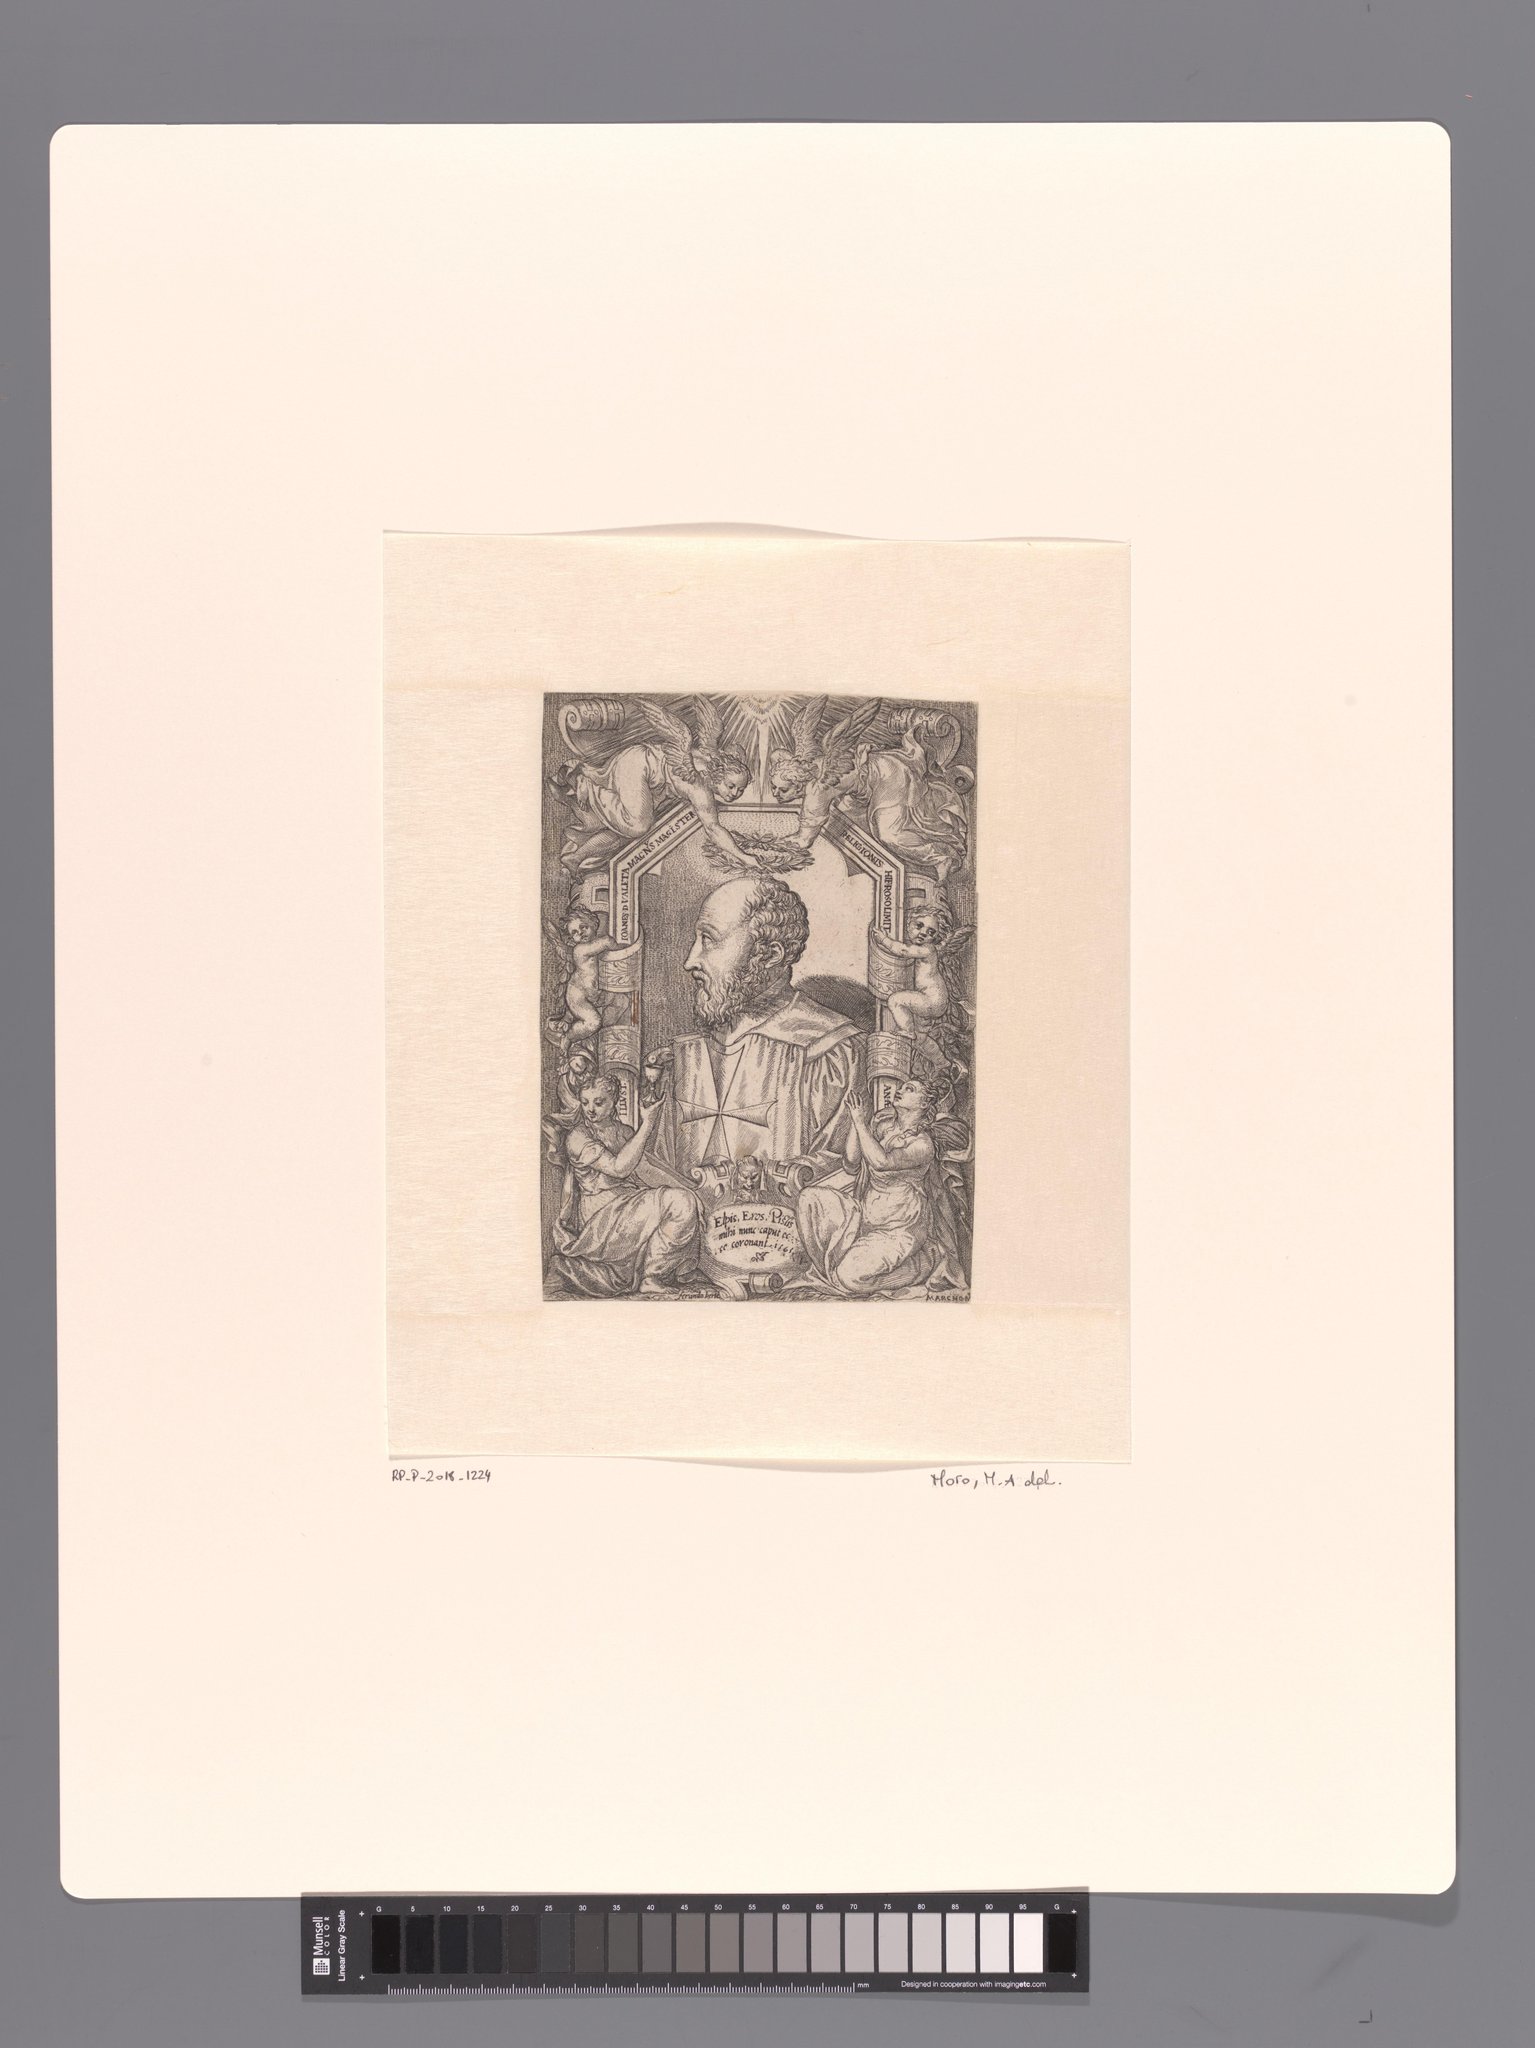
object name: print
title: Portret van Jean Parisot de La Valette, grootmeester van de Orde van Malta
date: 1565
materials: paper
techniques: engraving, etching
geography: venice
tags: historical persons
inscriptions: collector's mark: Lugt 2760, collector's mark: Lugt 2228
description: Portret van Giovanni da Valletta (Jean de la Valette) omgeven door een ornamentele rand, vier engelen en twee putti.